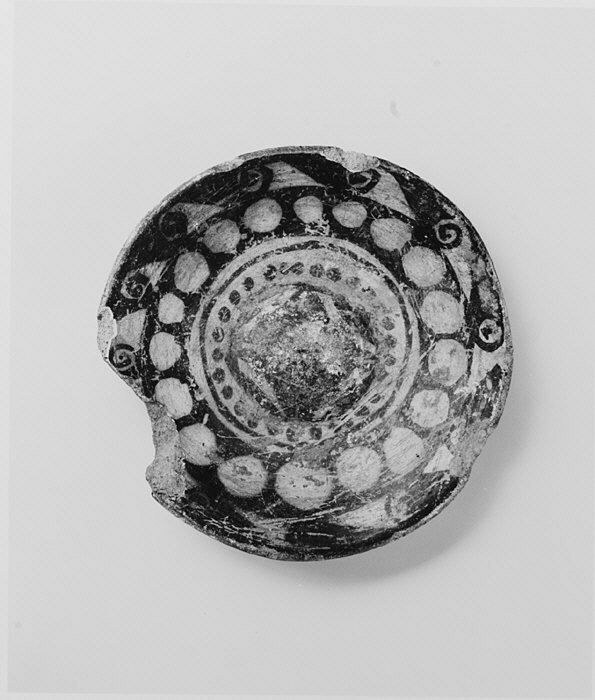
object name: plate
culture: islamic or kushan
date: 1-1000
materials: ceramic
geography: central asia